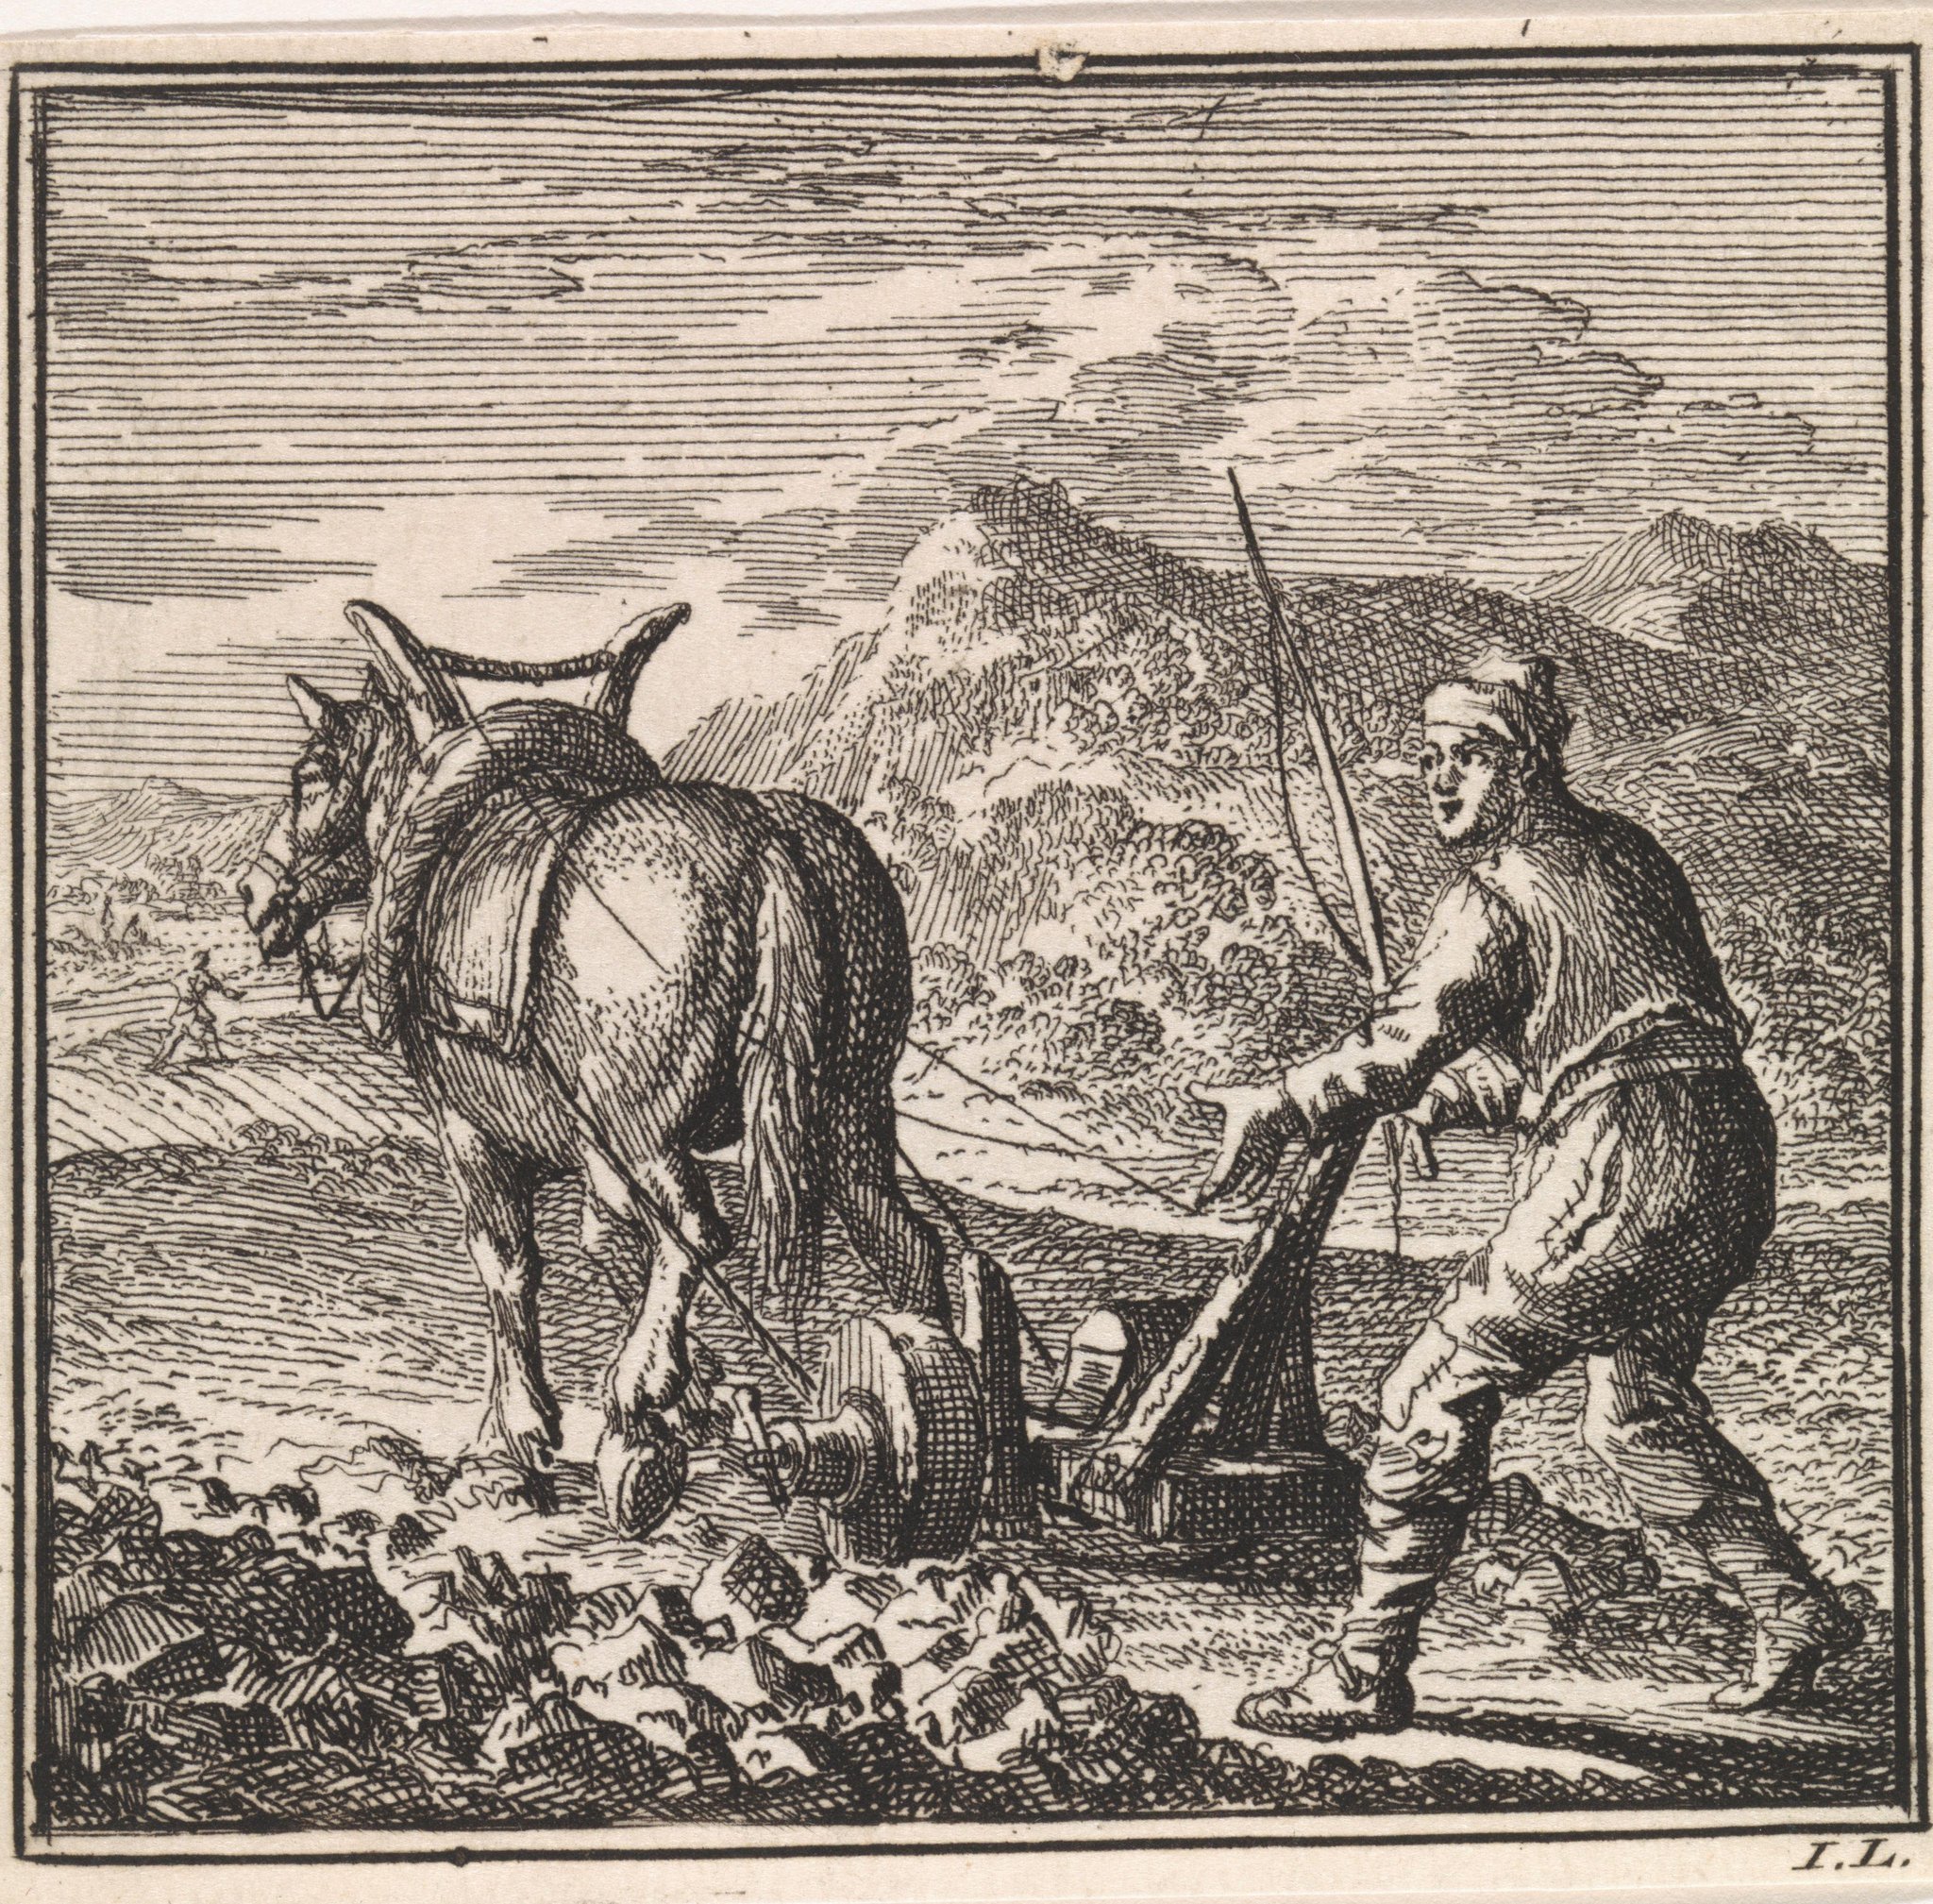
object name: print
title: Man ploegt een akker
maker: jan luyken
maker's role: draughtsman, print maker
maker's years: 1649-1712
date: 1711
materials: paper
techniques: etching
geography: amsterdam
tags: agricultural implements: plough, ploughing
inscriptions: collector's mark: Lugt 2228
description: Illustratie voor: Luyken, Jan. De Bykorf des Gemoeds. Amsterdam: Pieter Arentsz. II (wed.) en Cornelis van der Sys, 1711, p. 42.